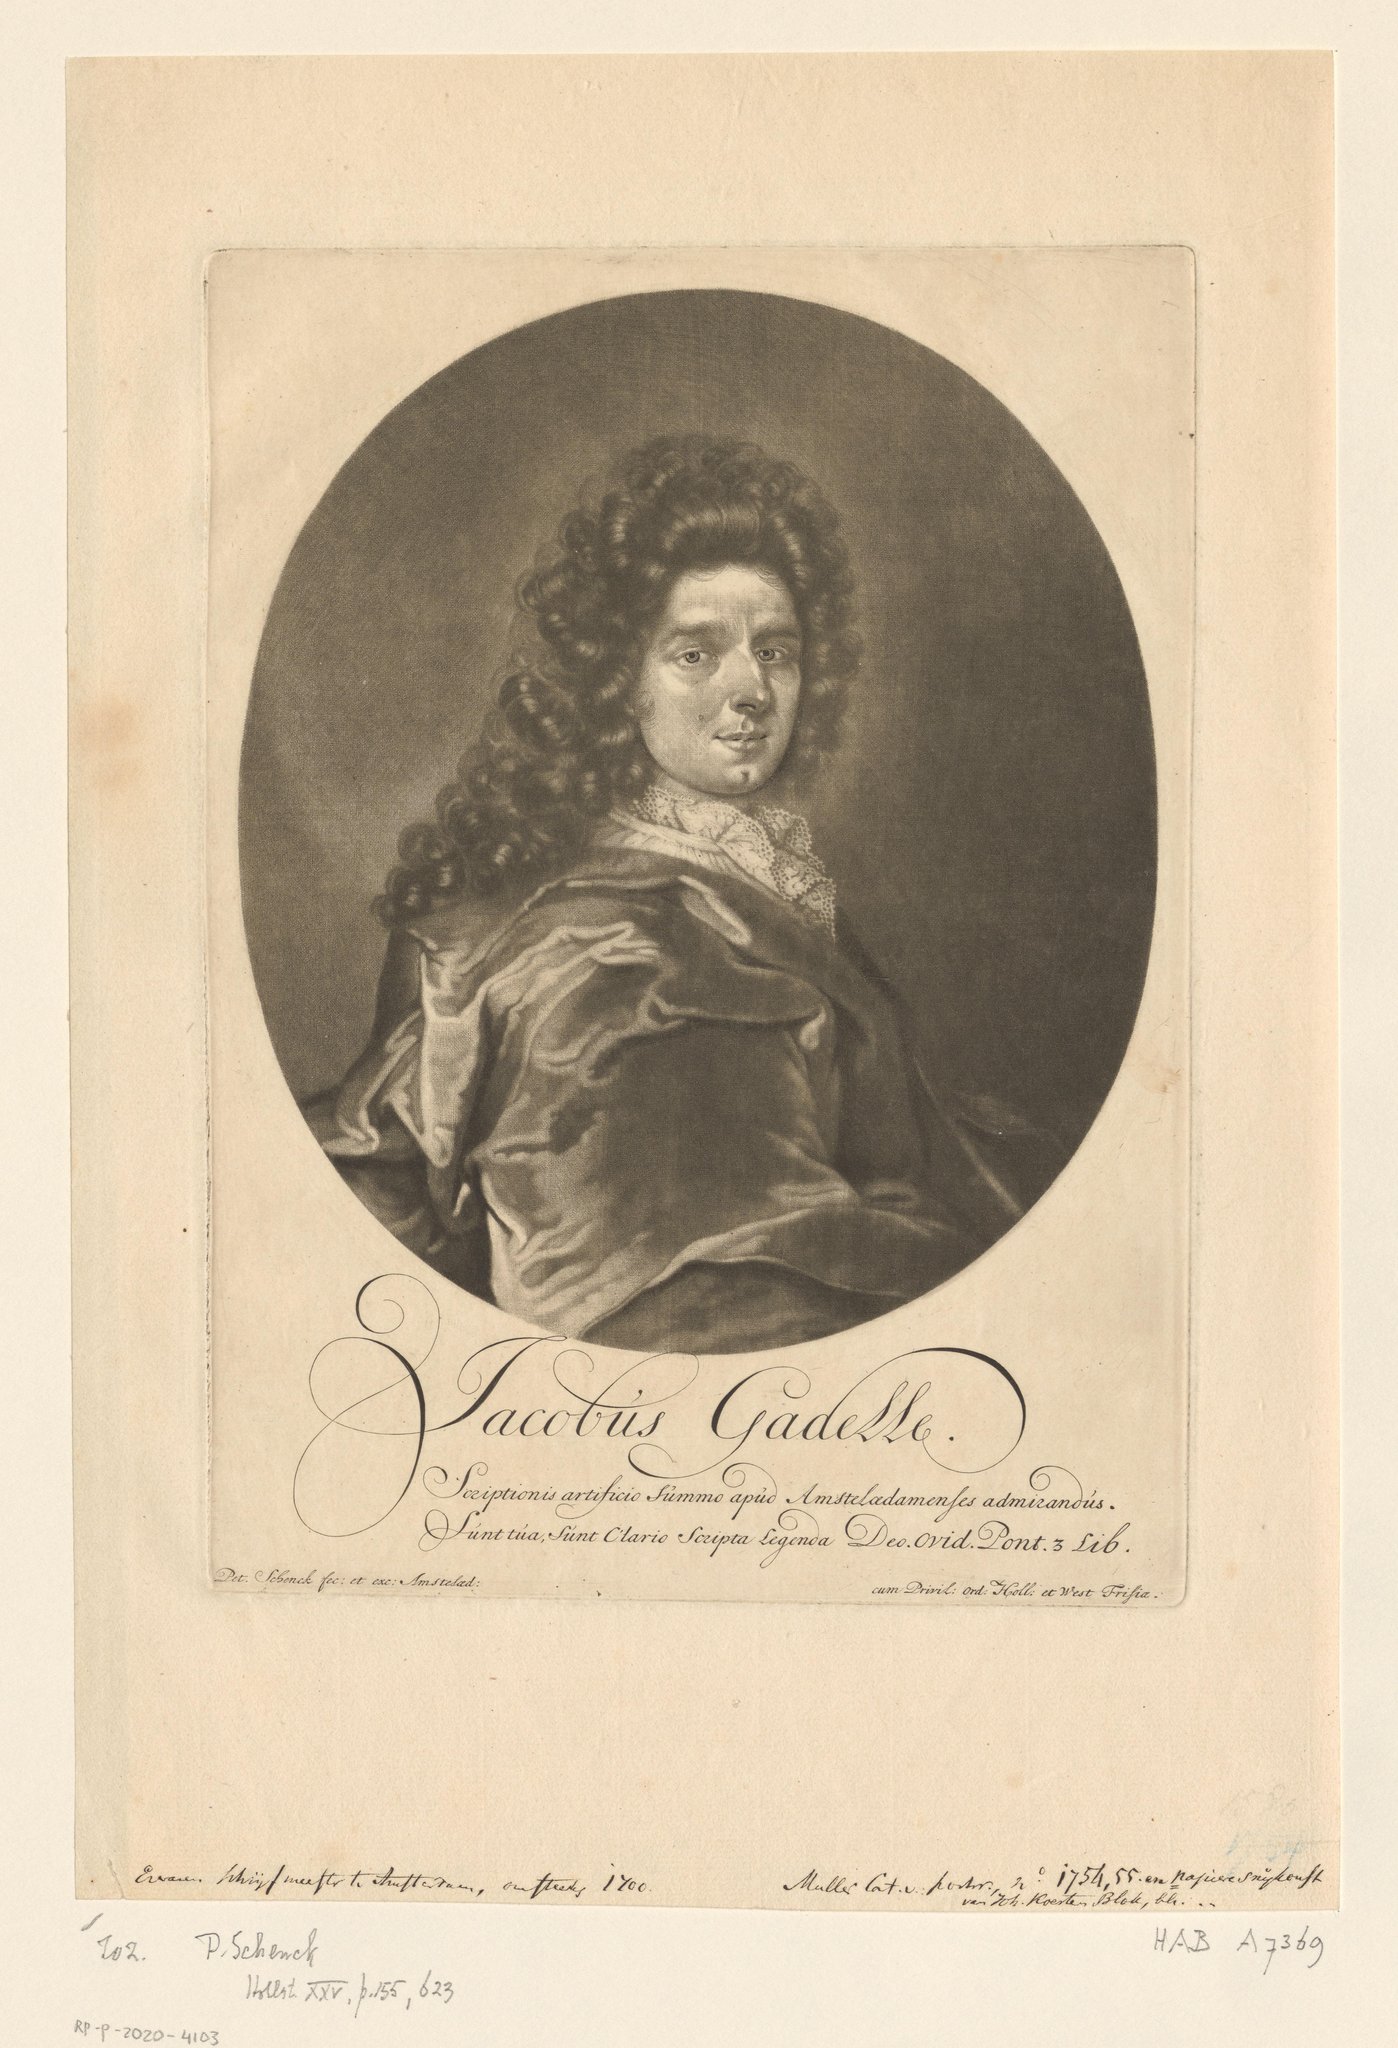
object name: print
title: Portret van Jacob Gadelle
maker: pieter schenk (i)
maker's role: print maker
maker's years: 1660-1711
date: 1670-1711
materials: paper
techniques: engraving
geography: amsterdam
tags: jacobus gadelle, historical persons, calligraphy (+ portrait of scholar, scientist)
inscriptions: : ‘[...] omstreeks 1700/ Muller cat. v. [...]’, collector's mark: Lugt 2228